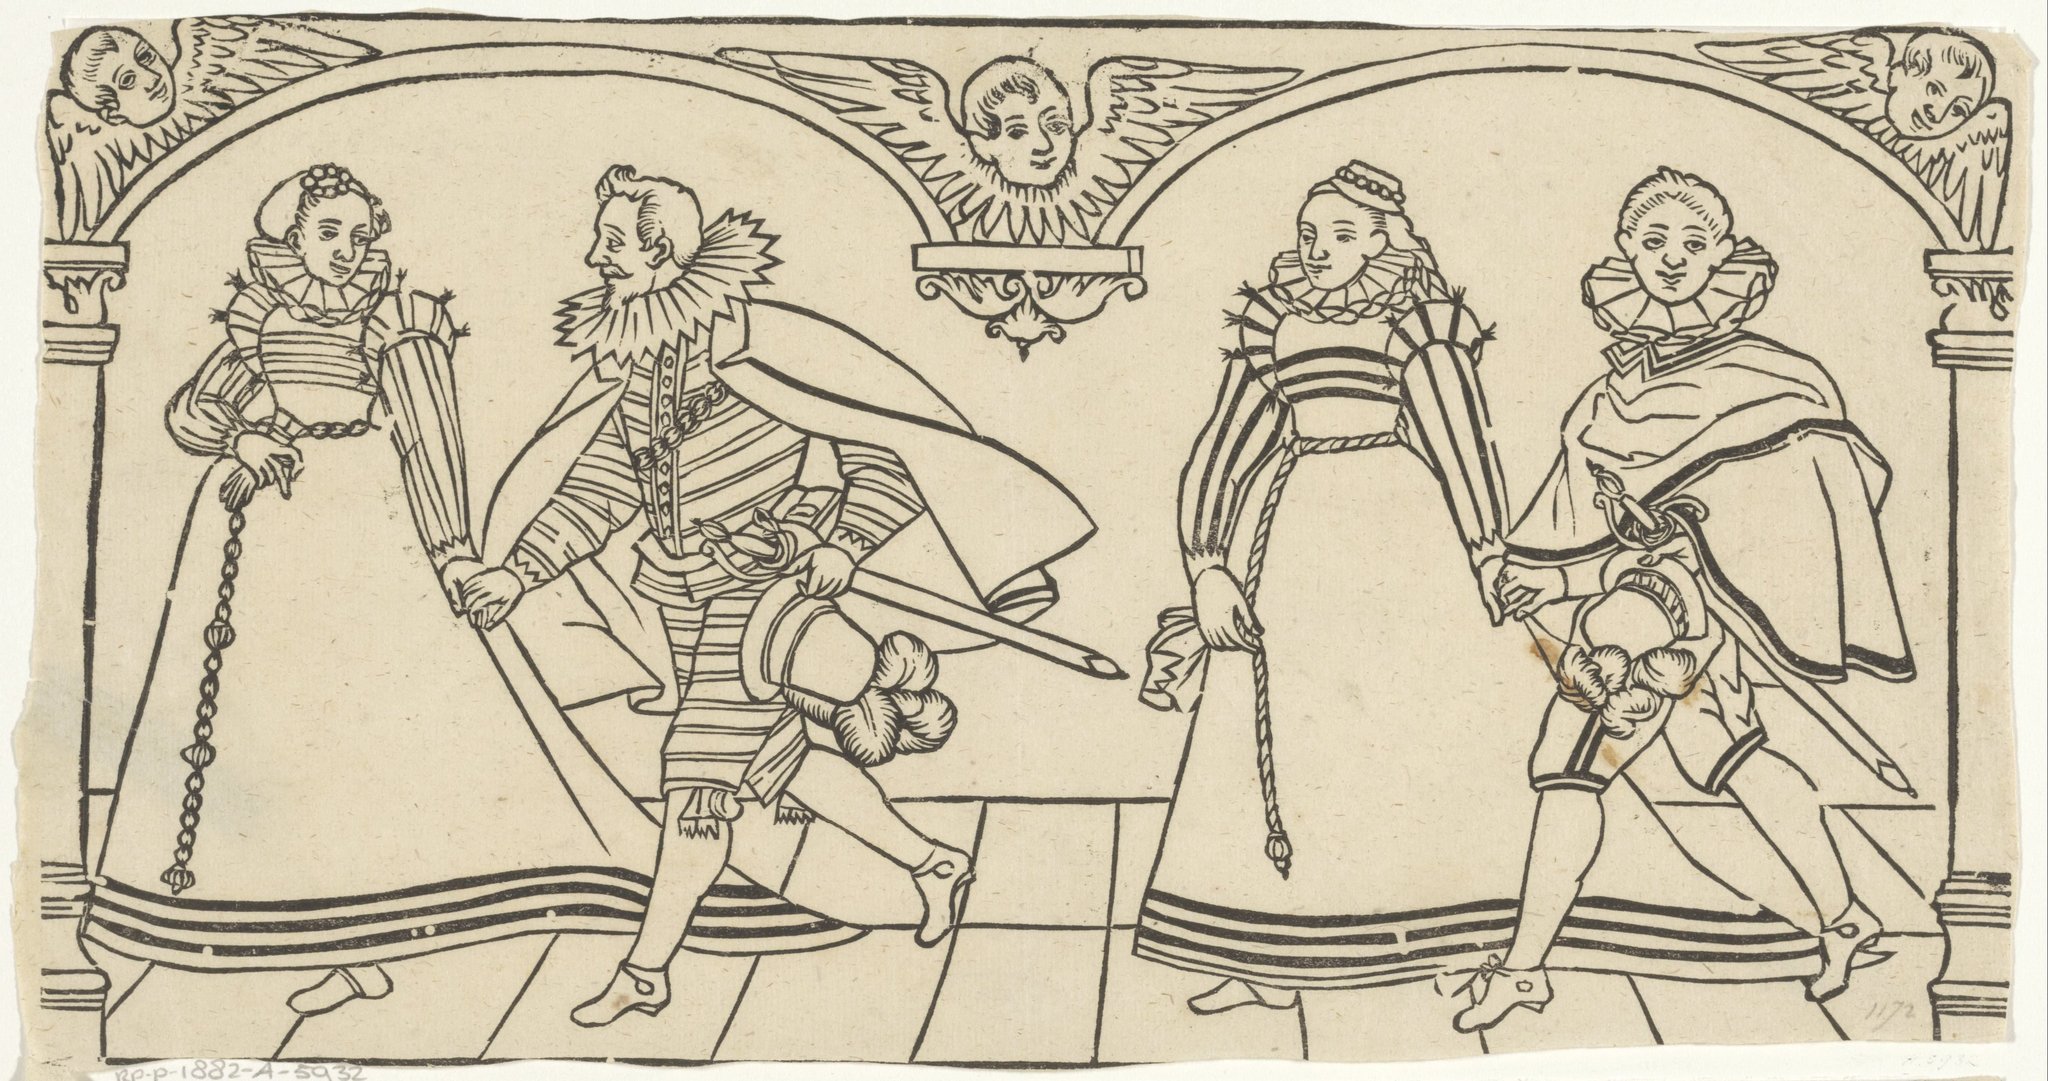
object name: print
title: Twee dansende paren op een bal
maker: Anonymous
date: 1600-1699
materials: paper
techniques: woodcut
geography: netherlands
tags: 43a23(+4)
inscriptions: collector's mark: Lugt 2228